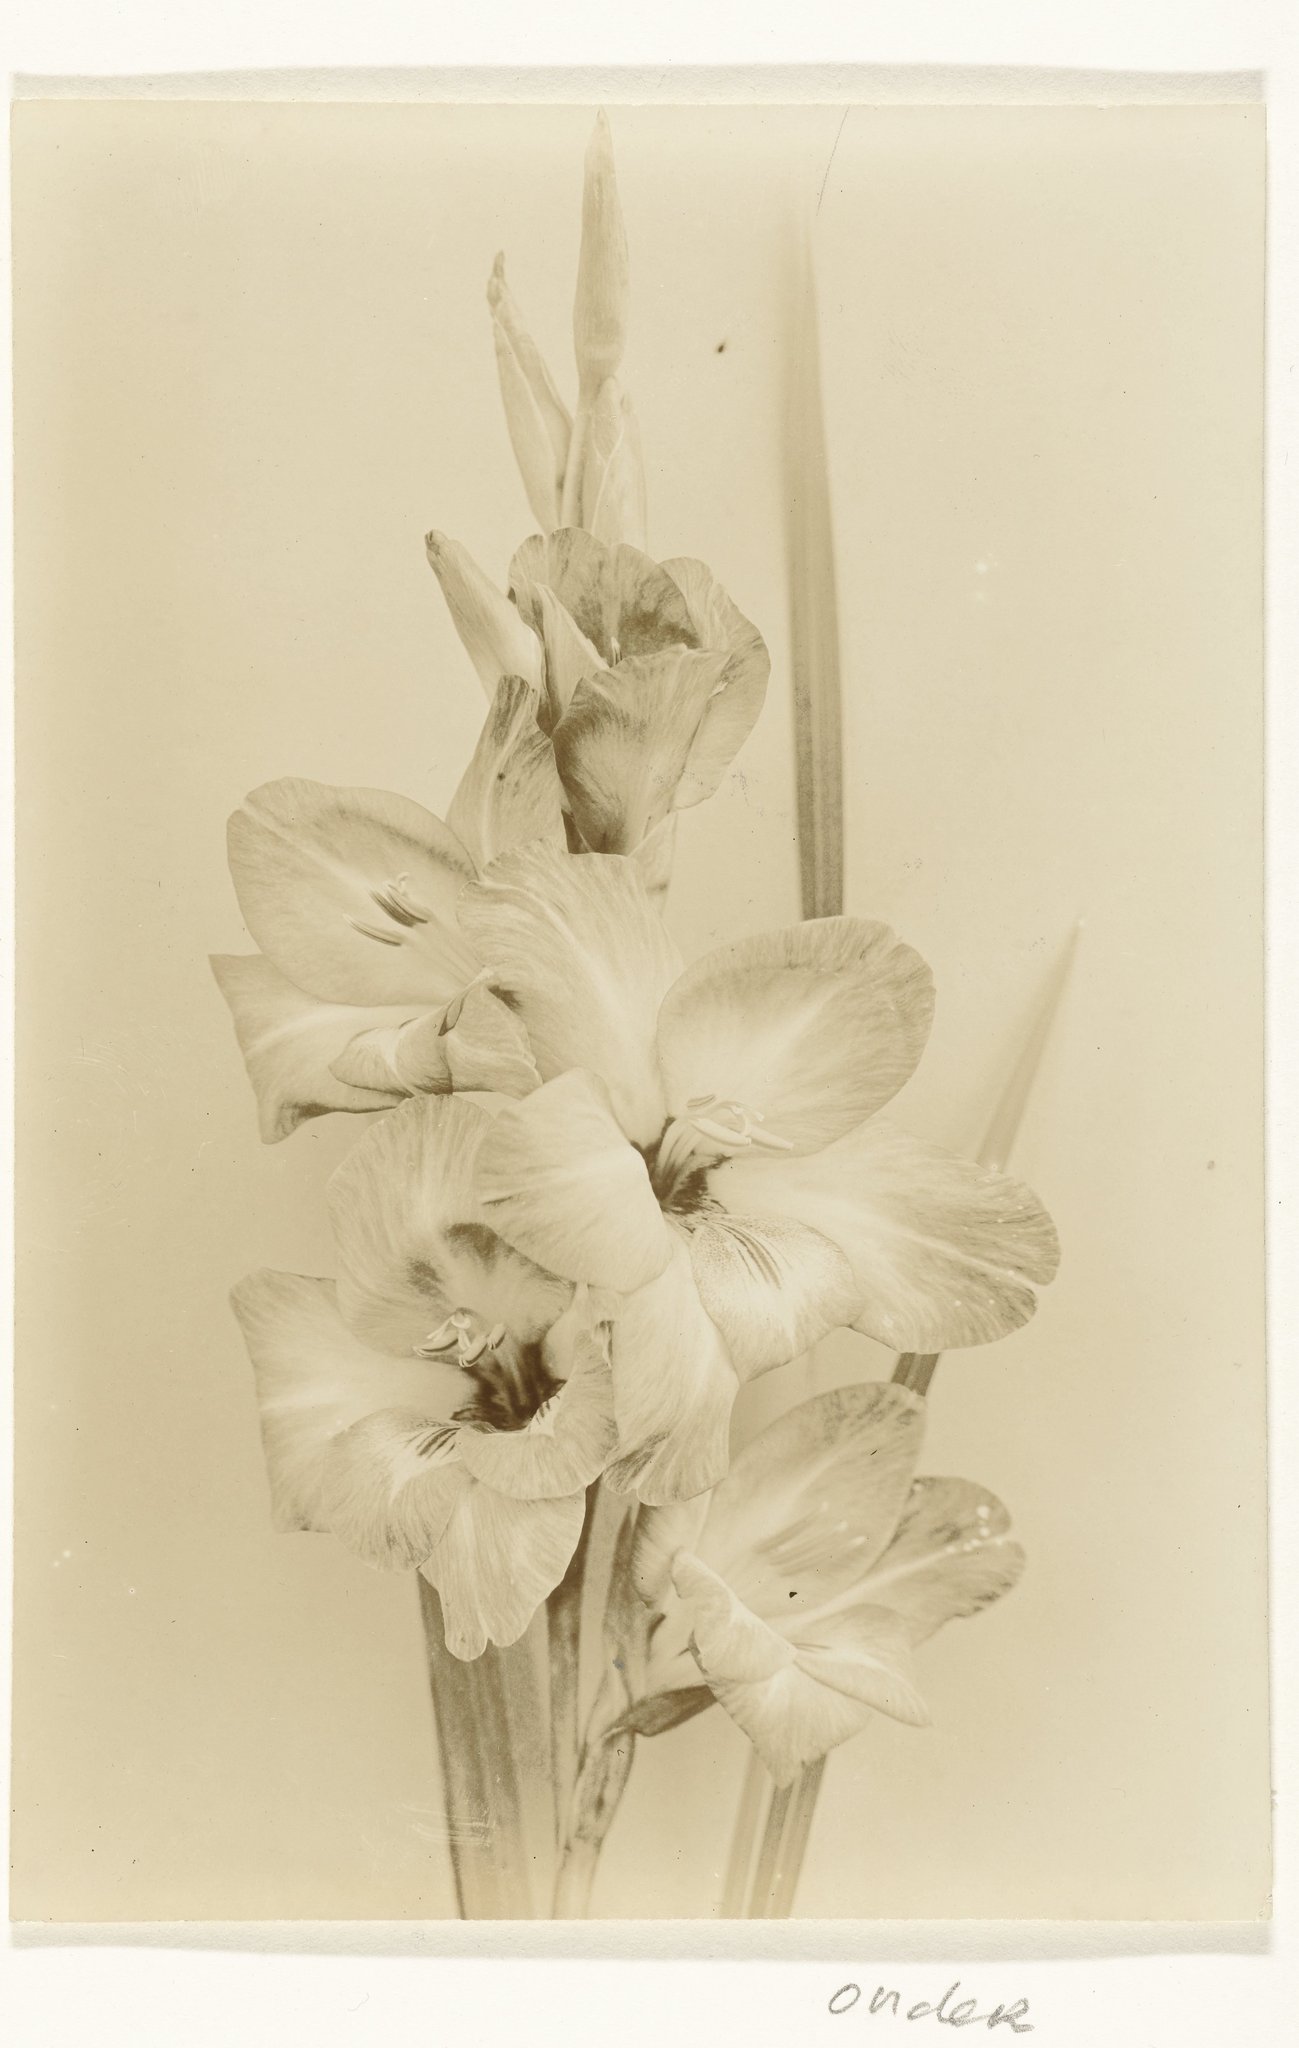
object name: photograph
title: Tak van een gladiool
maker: richard tepe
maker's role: fotograaf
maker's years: 1864-1952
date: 1900-1930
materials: photographic support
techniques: gelatin silver print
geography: netherlands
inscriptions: annotation: ‘Gladiole / "Halley"’, signature: ‘foto / R Tepe’